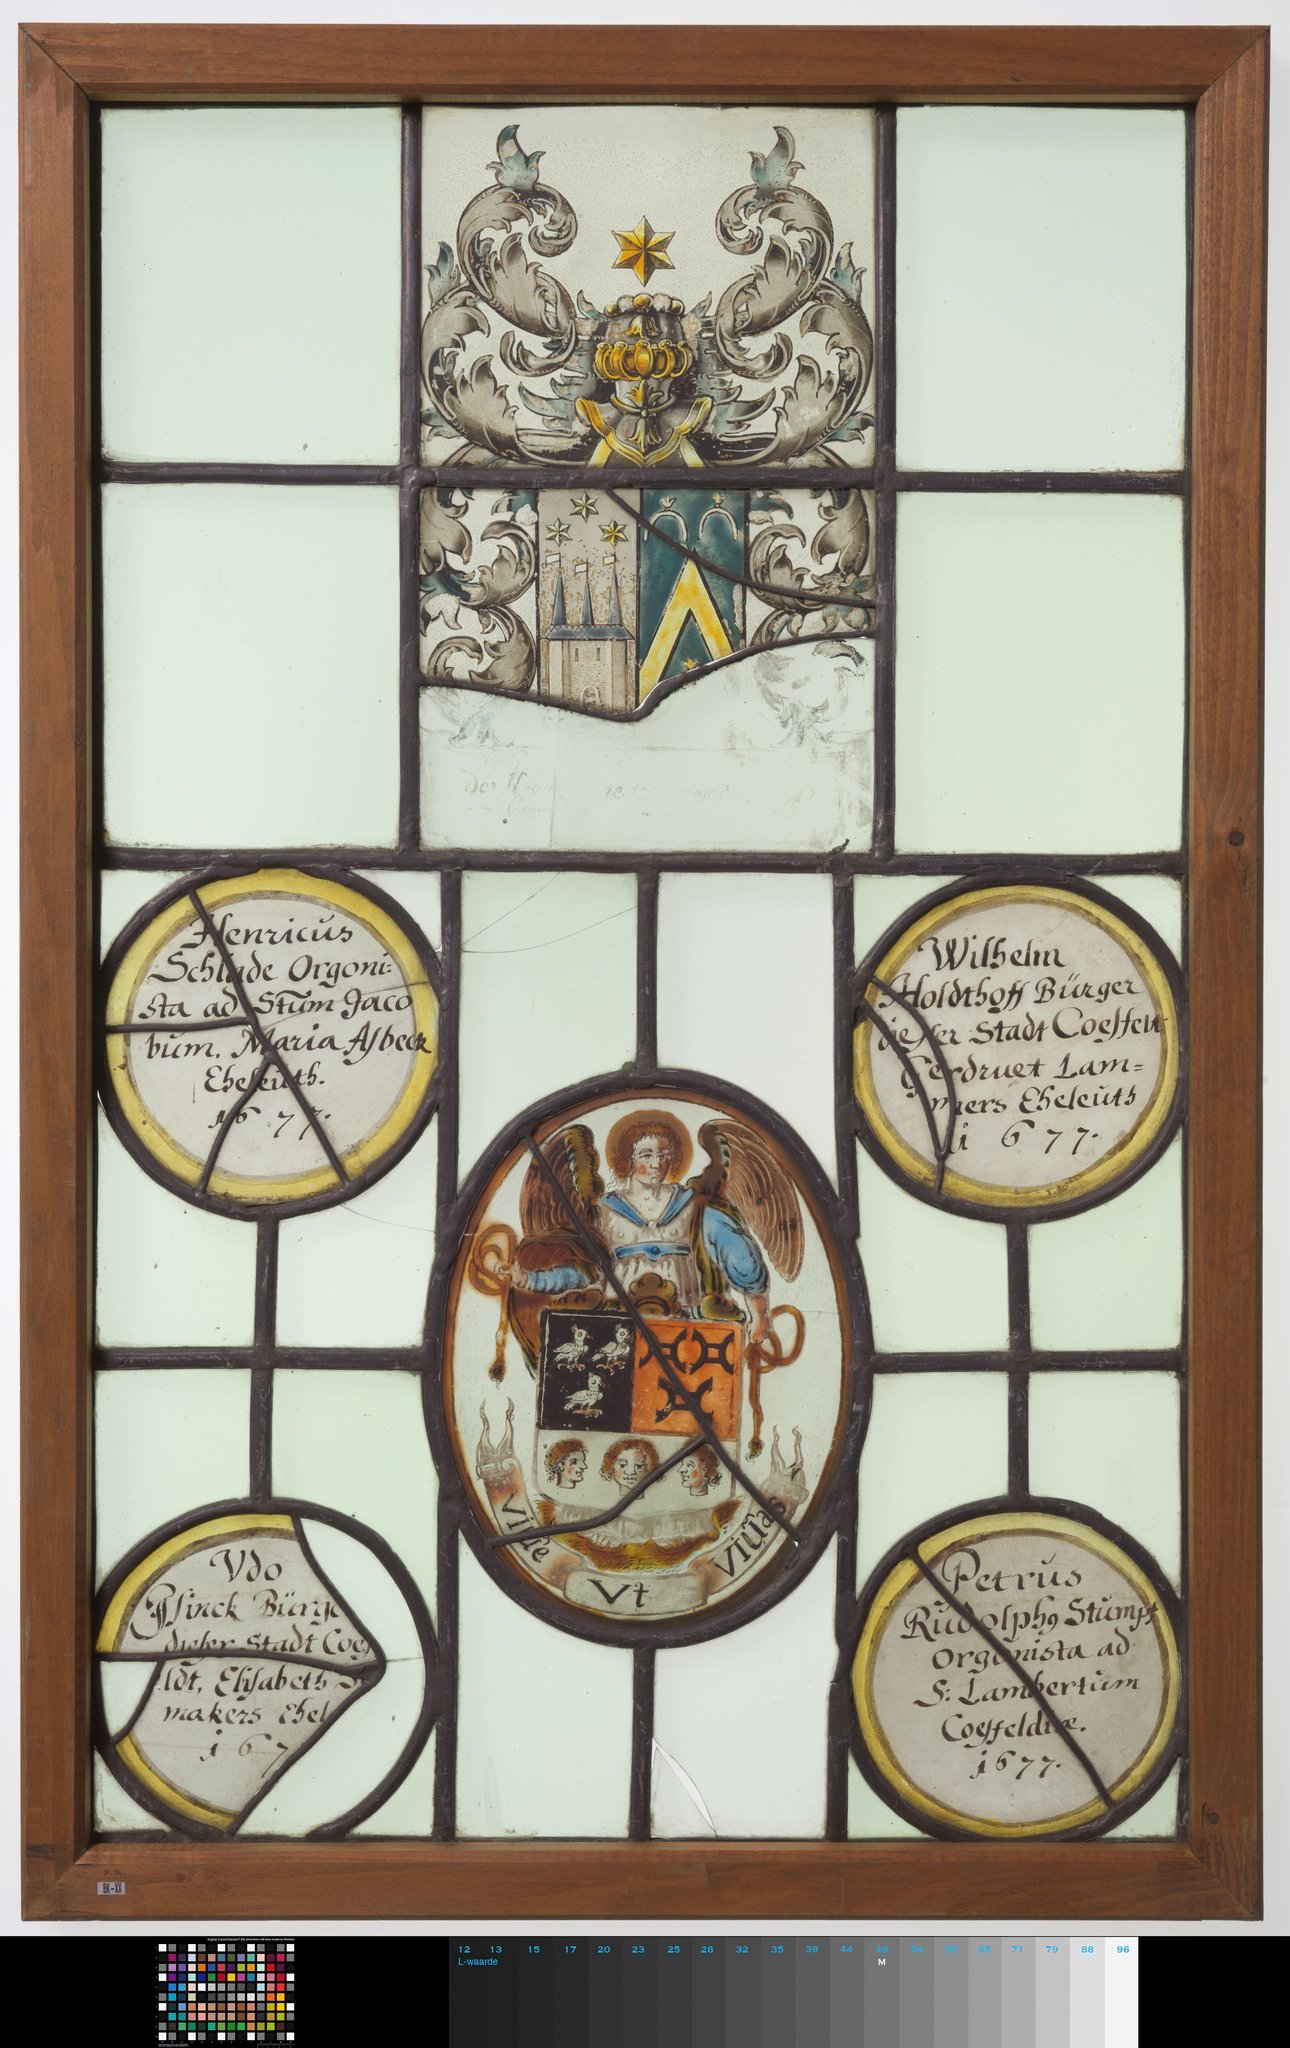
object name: light window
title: Ruit met wapenschilden met o.a. een kasteel met drie torenspitsen, drie hoofdjes en vier ronde ruiten met tekst waaronder "Henricus, Wilhelm, Petrus en Udo..."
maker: Anonymous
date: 1600-1699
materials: glass, lead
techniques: leading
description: Ruit waarin zeven geschilderde ruiten. Twee van deze vormen een wapen. Met onderschrift. In de linkerhelft van het wapenschild onder meer een kasteel met drie torenspitsen.